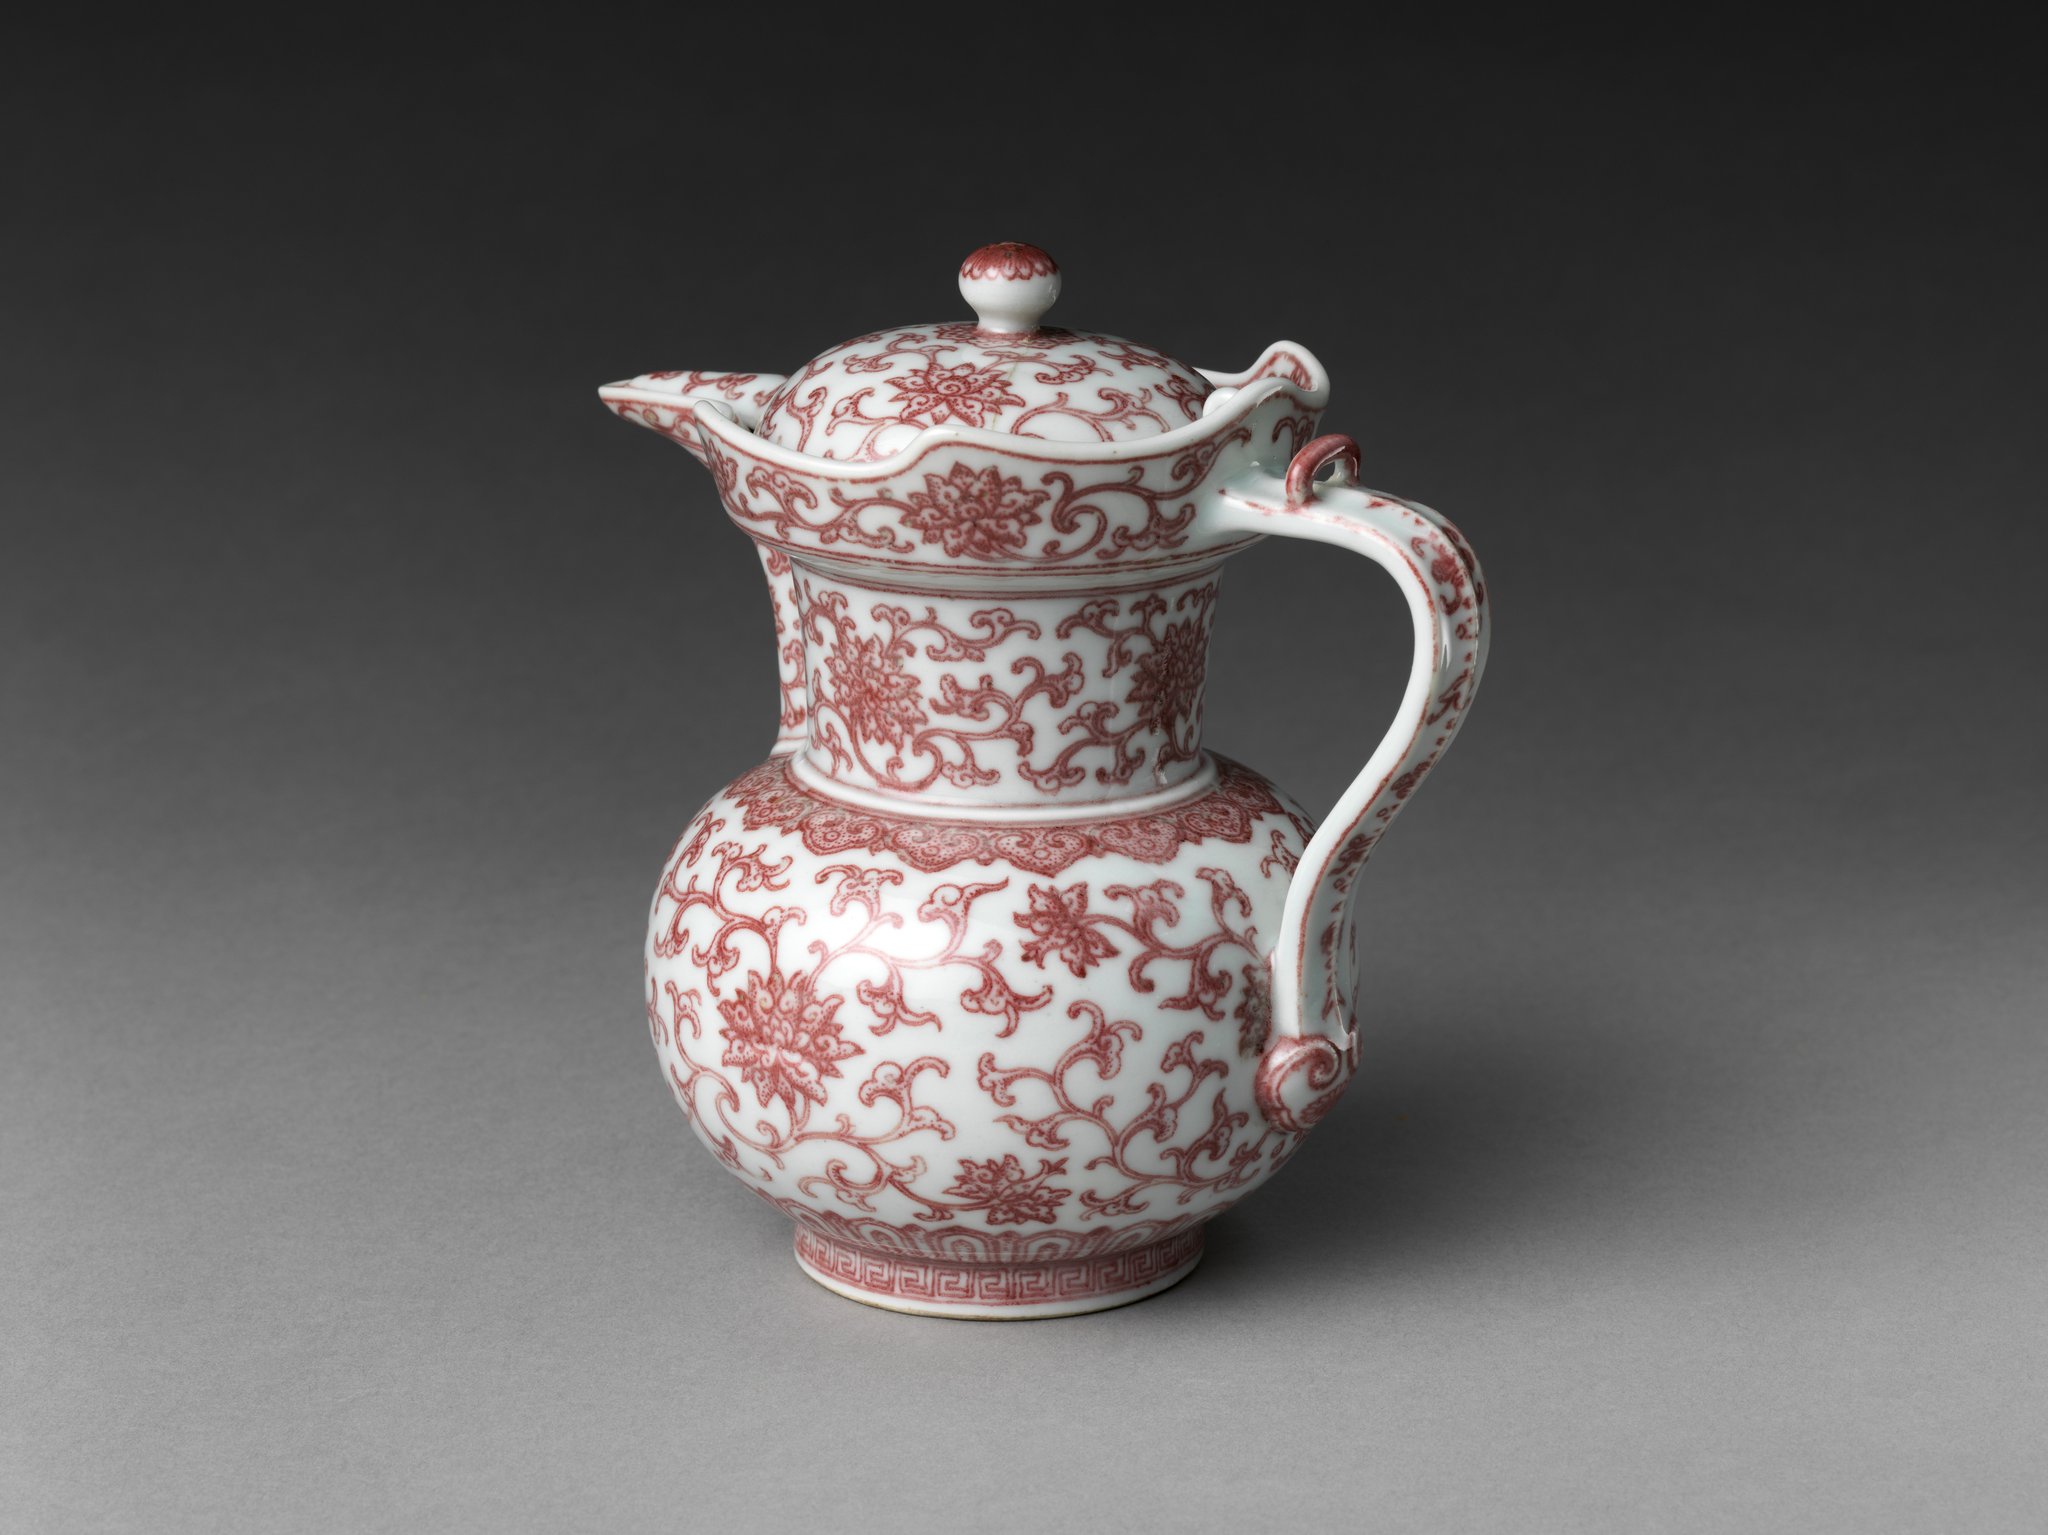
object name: ewer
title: Ewer in Shape of Tibetan Monk’s Cap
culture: chinese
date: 1734-1766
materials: copper, glaze, porcelain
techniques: painting